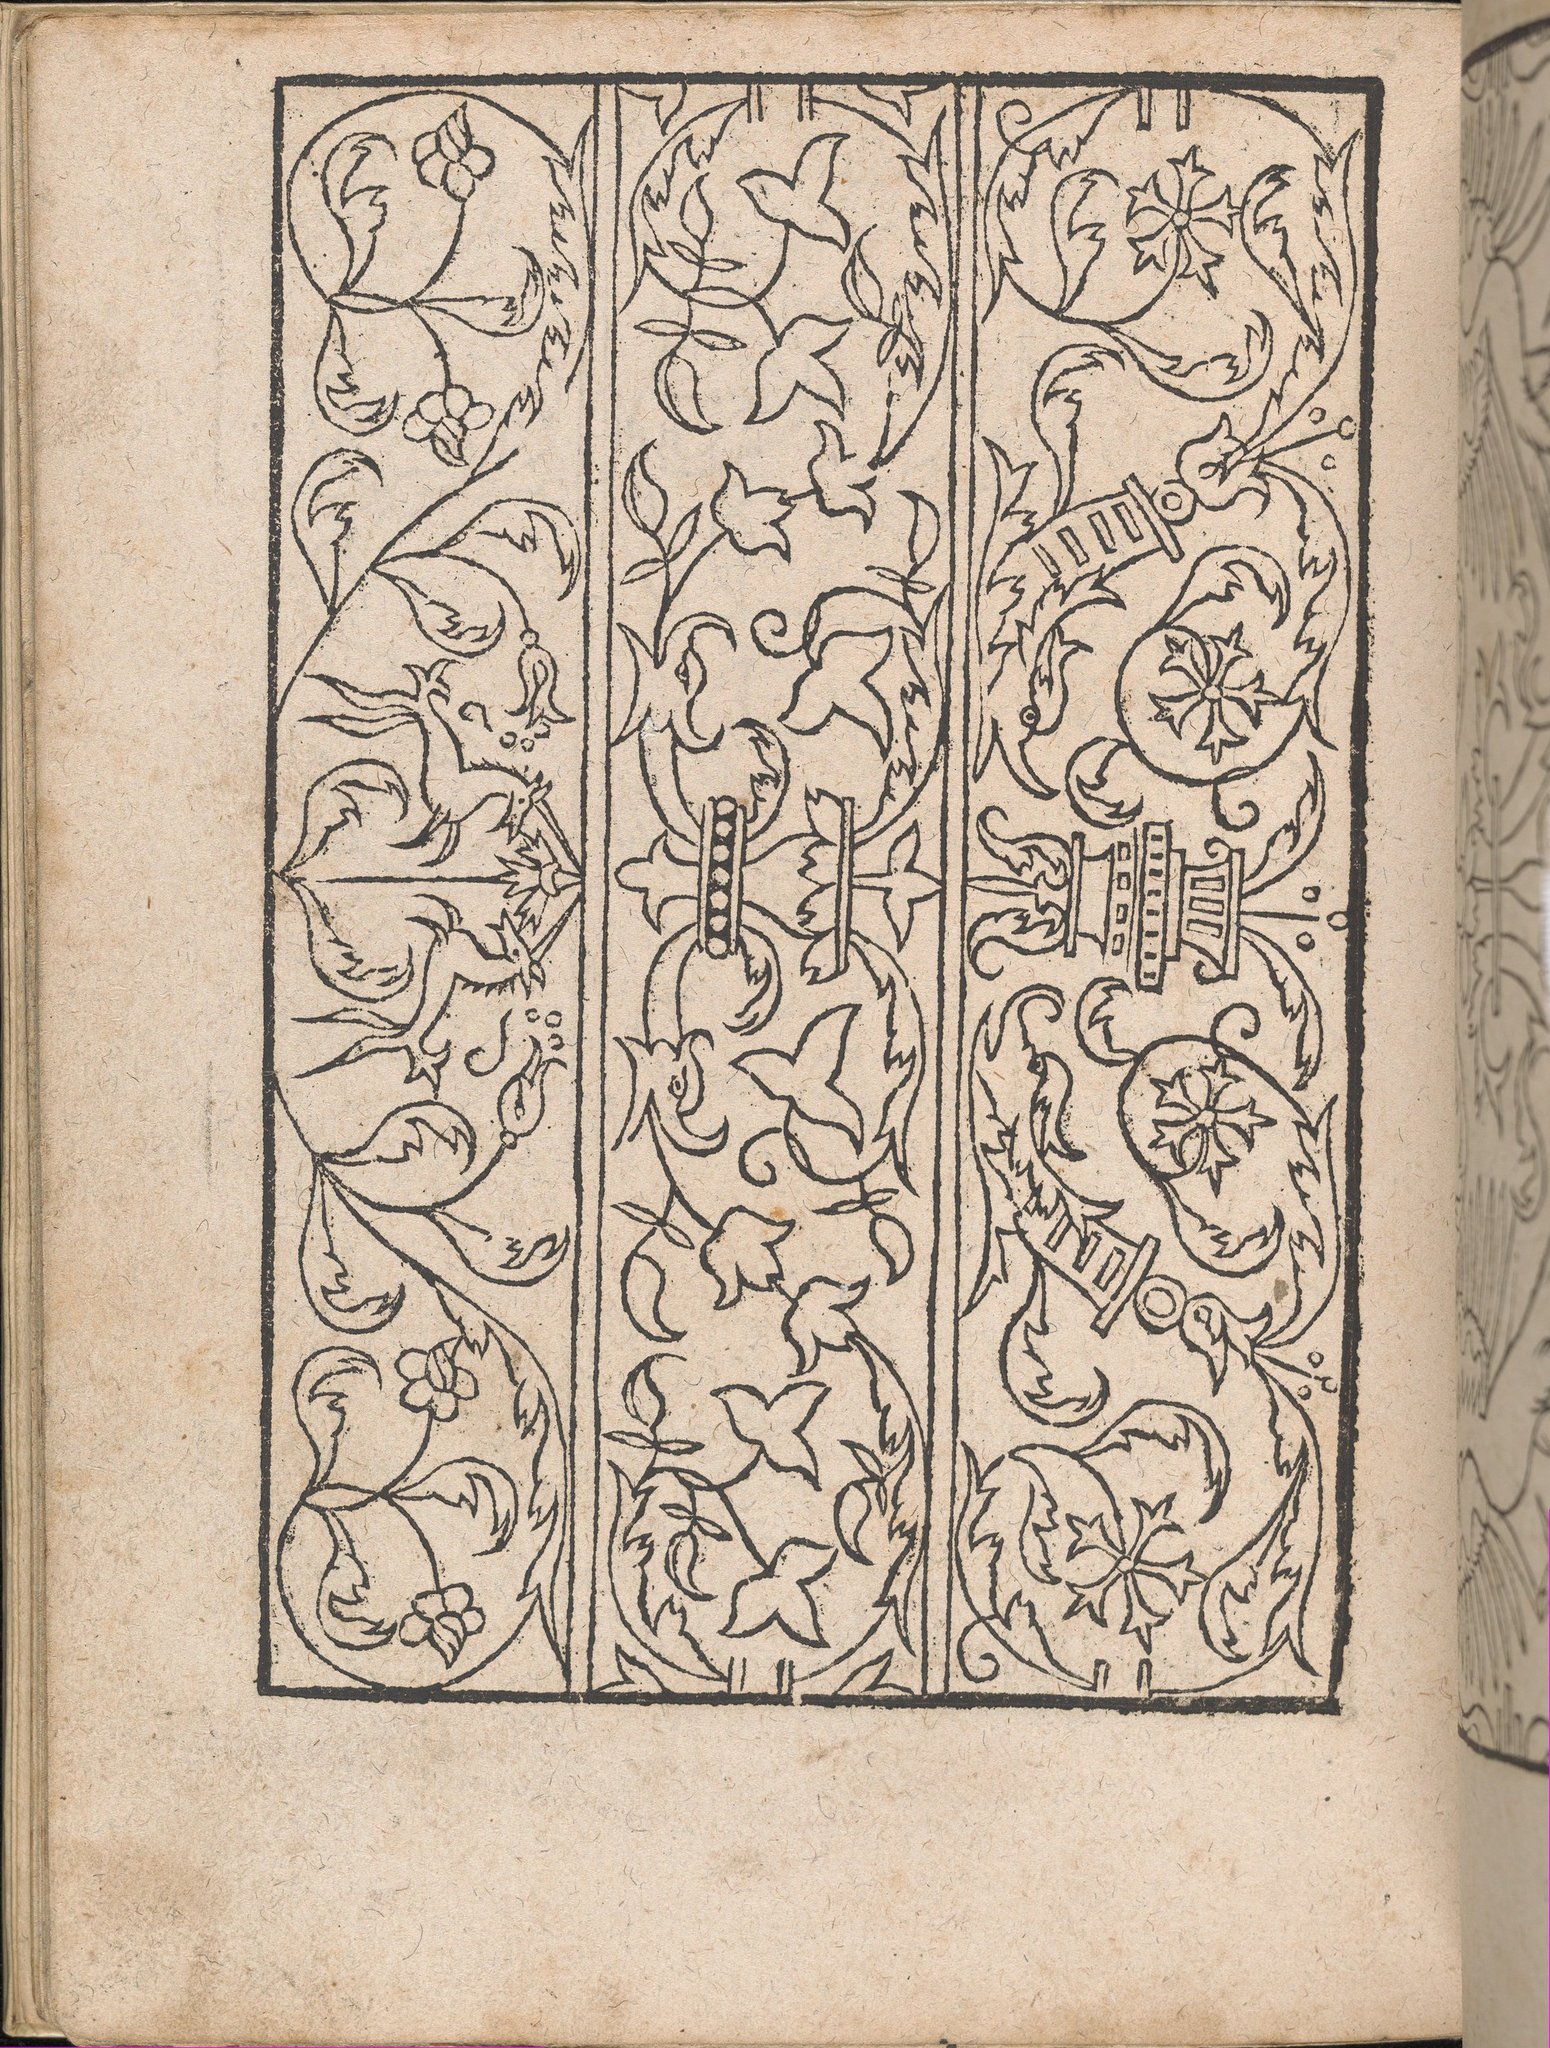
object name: book print ornament architecture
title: New Modelbüch allen Nägerin u. Sydenstickern (Page 21v)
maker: hans hoffman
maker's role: designer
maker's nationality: german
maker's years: 1556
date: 1556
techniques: woodcut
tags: ornament